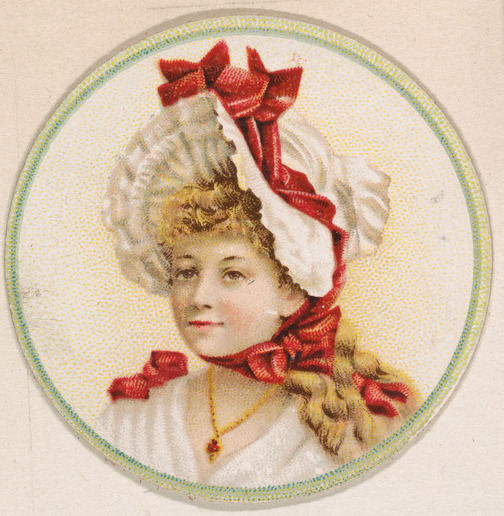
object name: print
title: Woman wearing hat with ribbons, from the Novelties series (N228, Type 2) issued by Kinney Bros.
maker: kinney brothers tobacco company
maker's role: publisher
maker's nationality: american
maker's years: 1869-2011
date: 1889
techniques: color lithograph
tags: women